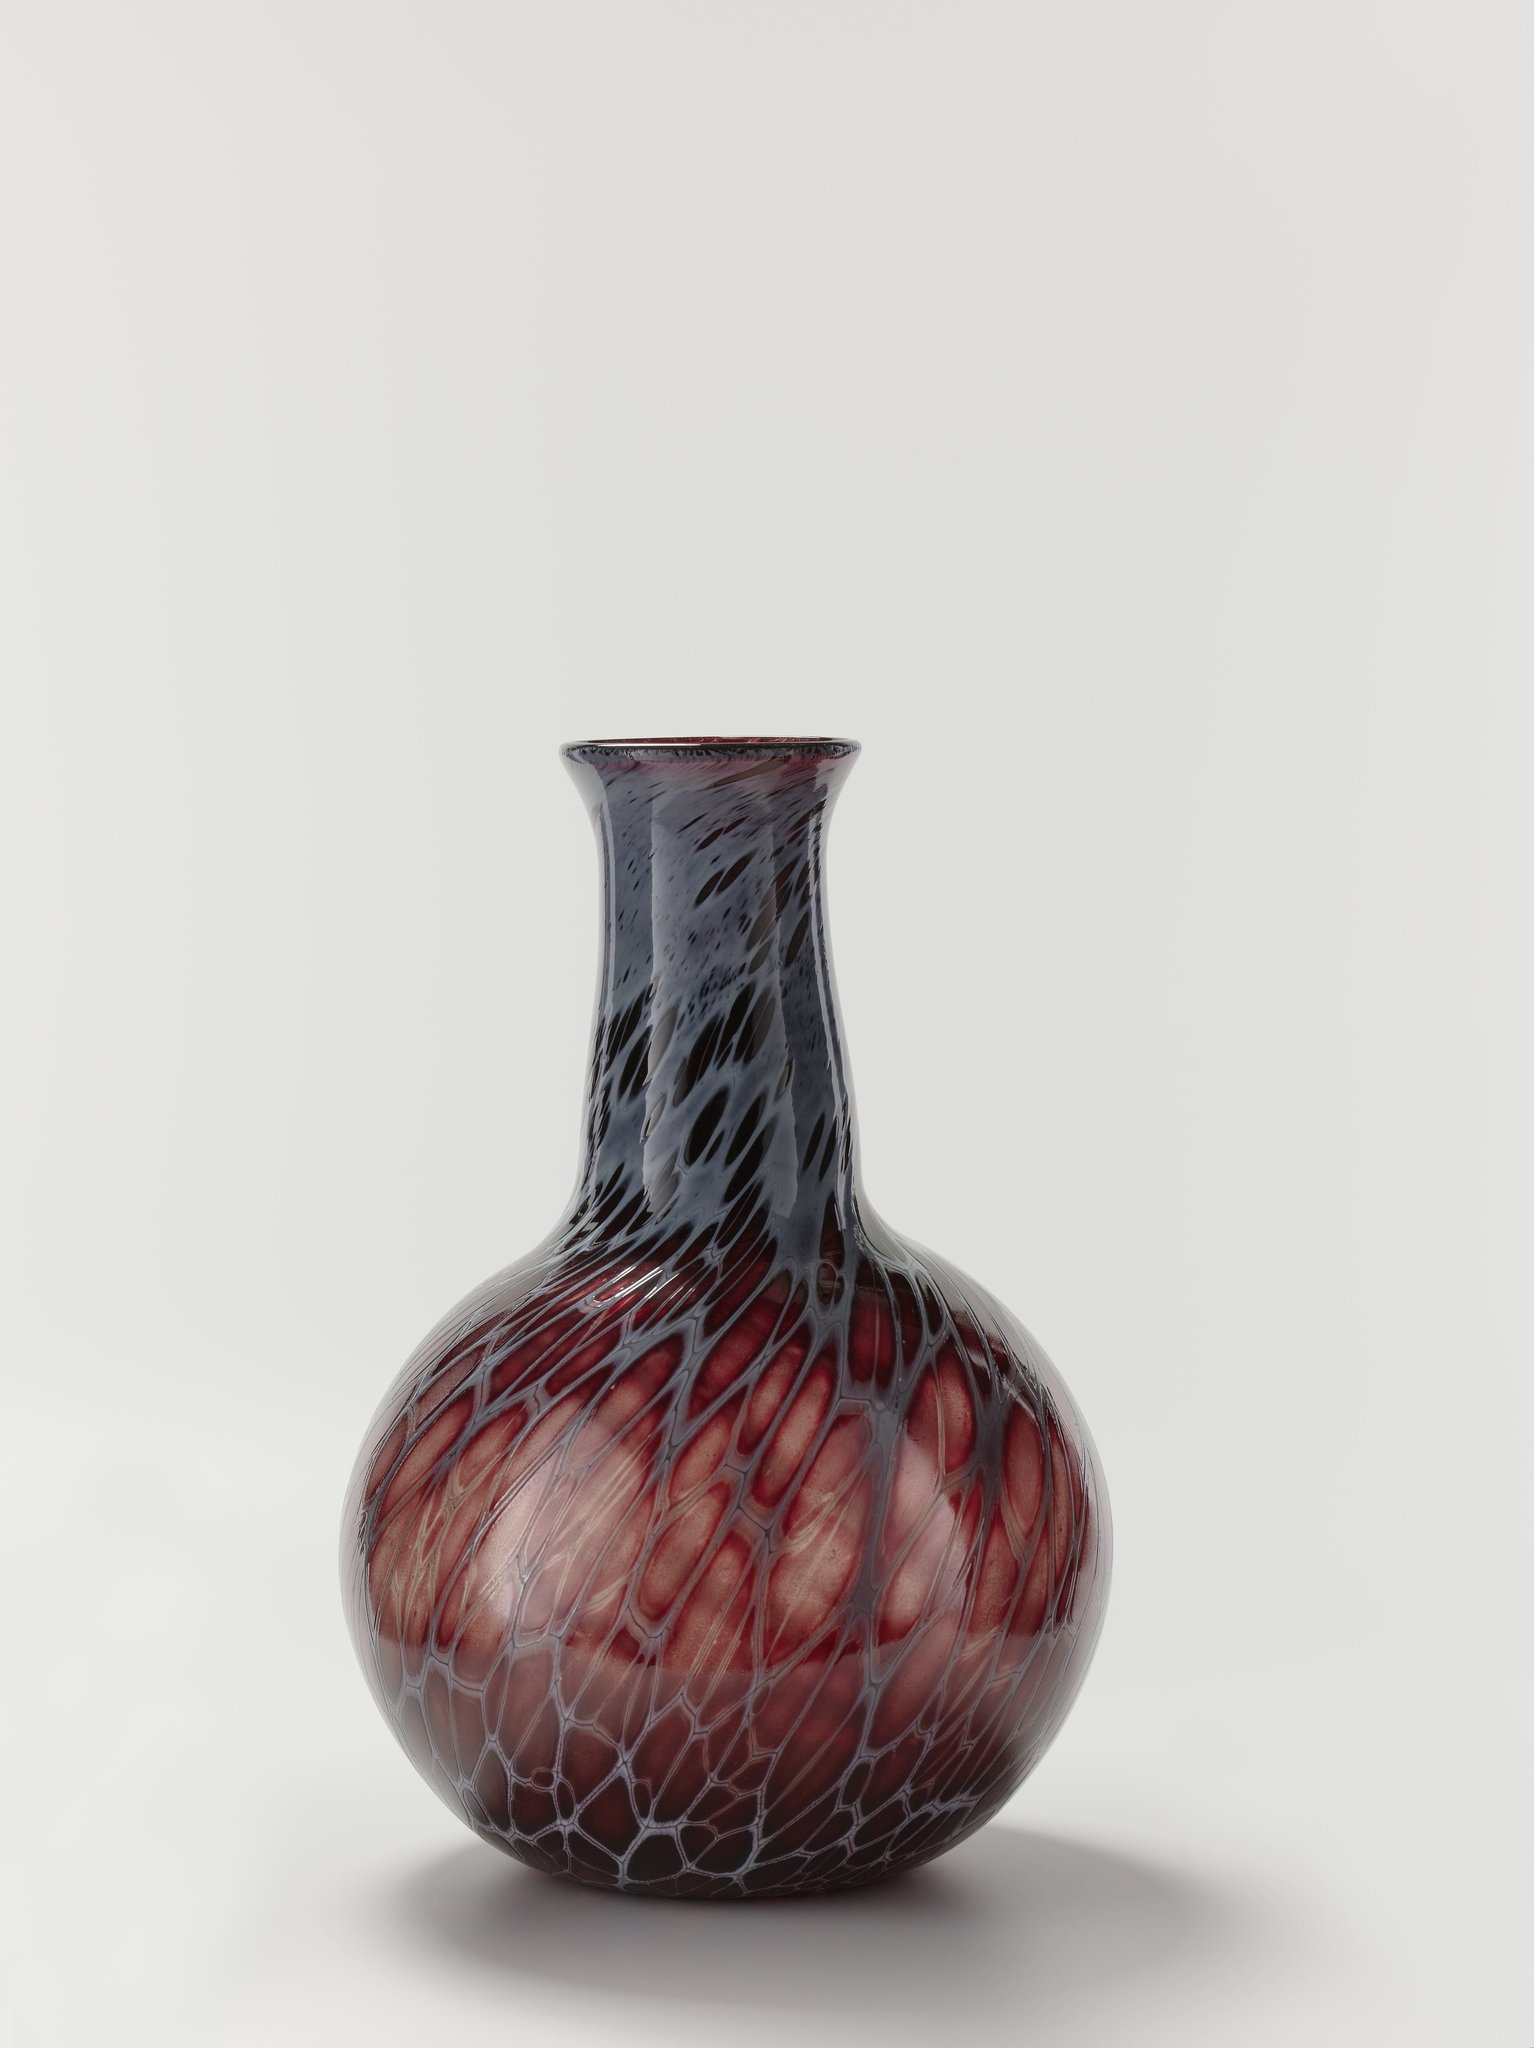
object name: vase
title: Vaas met ossebloedrode en witte Überfang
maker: chris lanooy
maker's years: 1881-1948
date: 1928-1929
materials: glass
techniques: glassblowing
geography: leerdam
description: Vaas van glas met licht ingestoken bodem. Bolvormig, vrij geblazen en gevormd lichaam, overgaand in een iets uitlopende hals. Kleurloze glasmassa met een Überfang van ossebloedrood glas, waarover een opaak witte laag, in een reducerend vuur opengebroken. Gemerkt met de diamant LEERDAM UNICA C.J. Lanooy E 60.